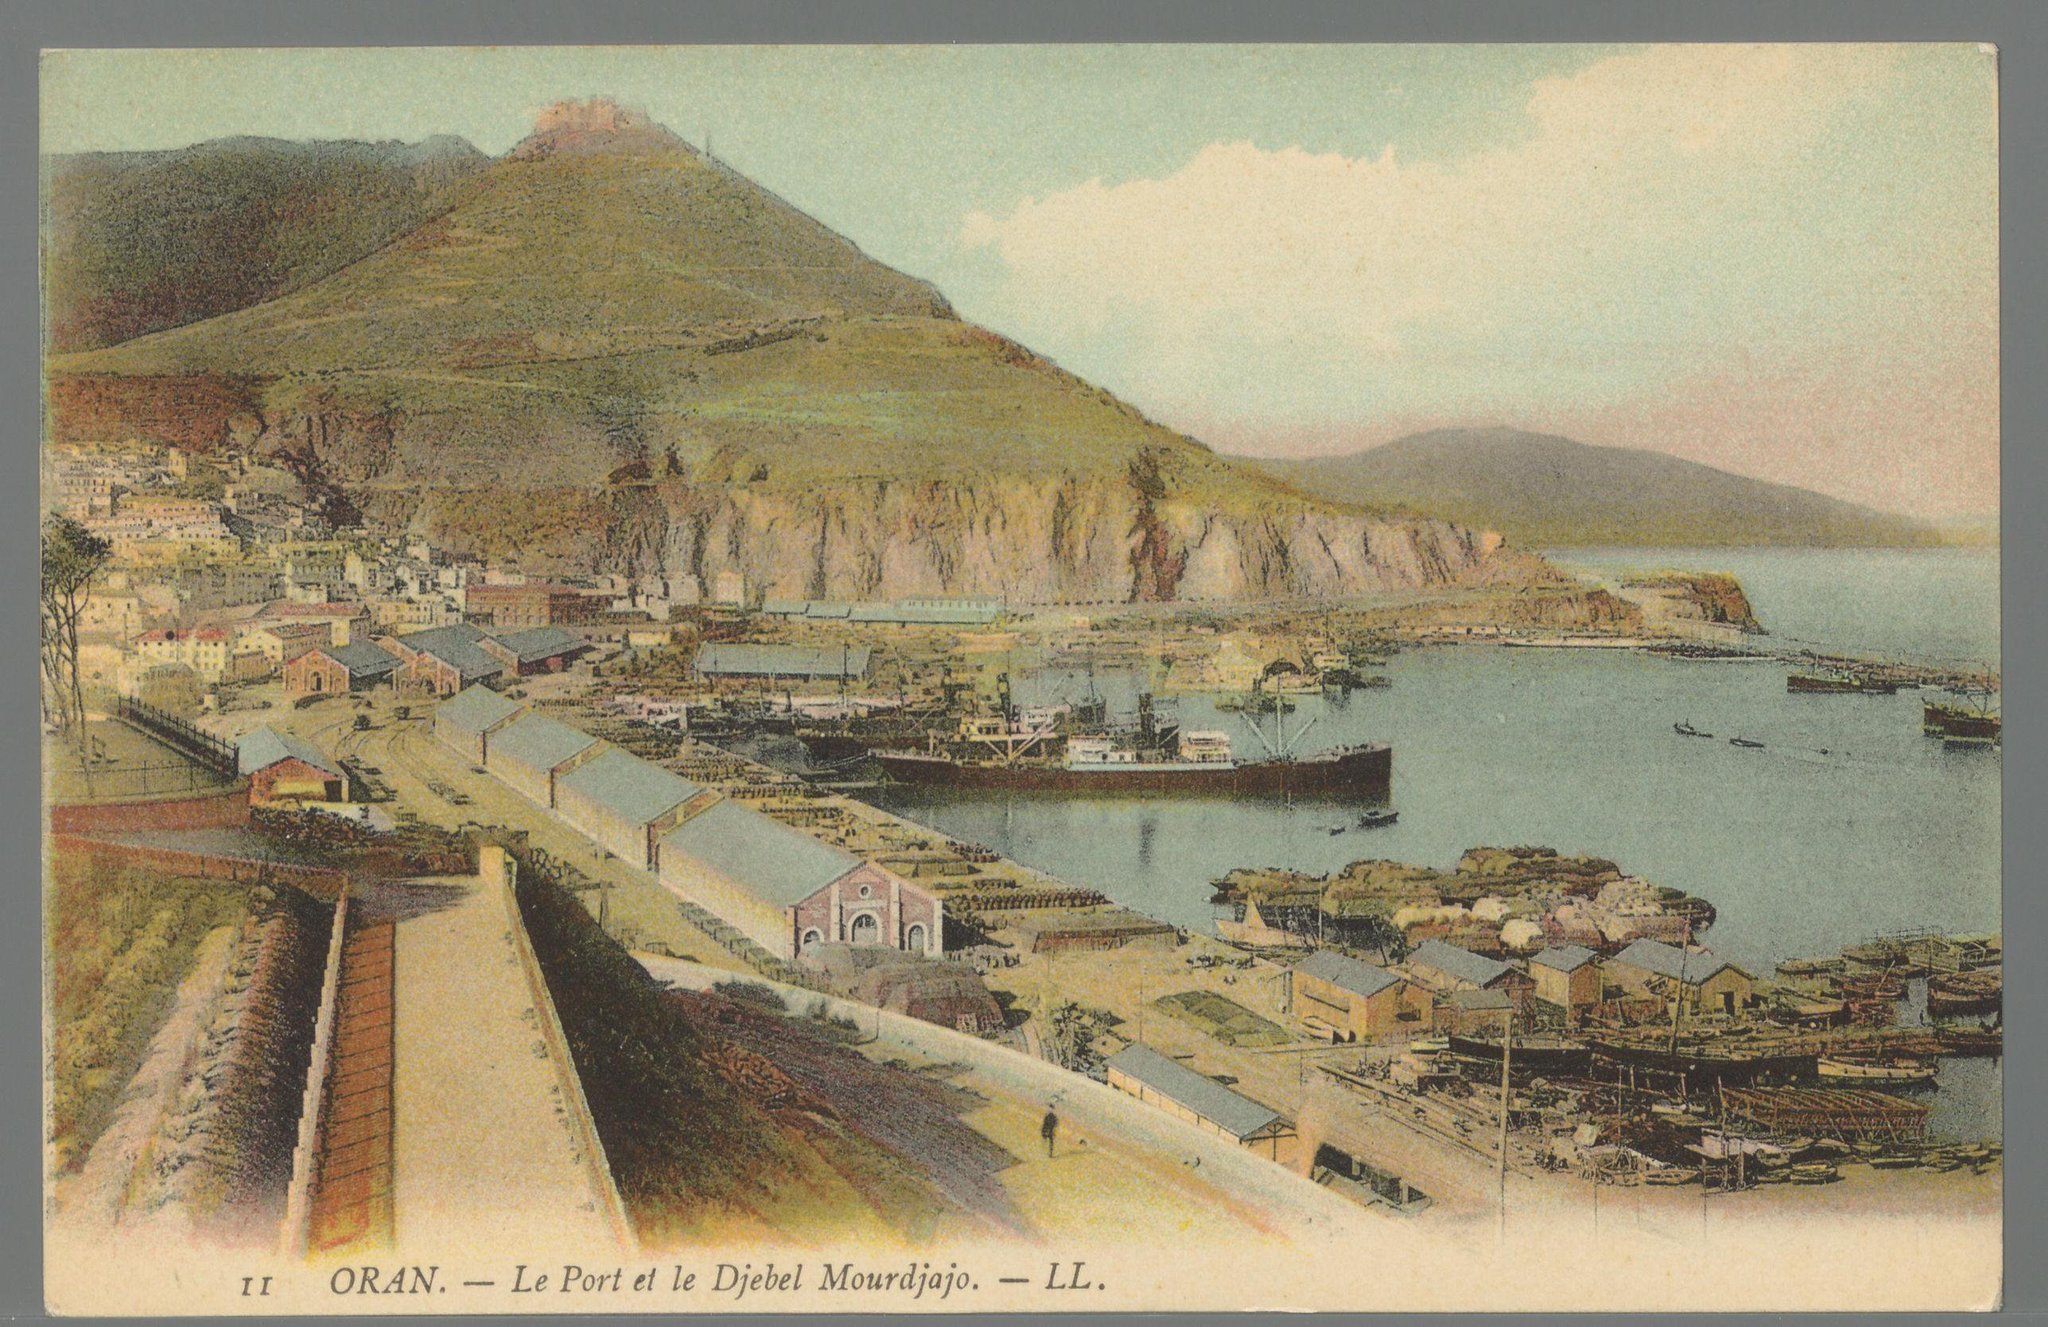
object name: photomechanical print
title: Oran. Le Port et le Djebel Mourdjajo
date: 1903-1905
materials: cardboard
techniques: photograph, lithograph, writing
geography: paris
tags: harbour, mountains (in tropical and sub-tropical regions)